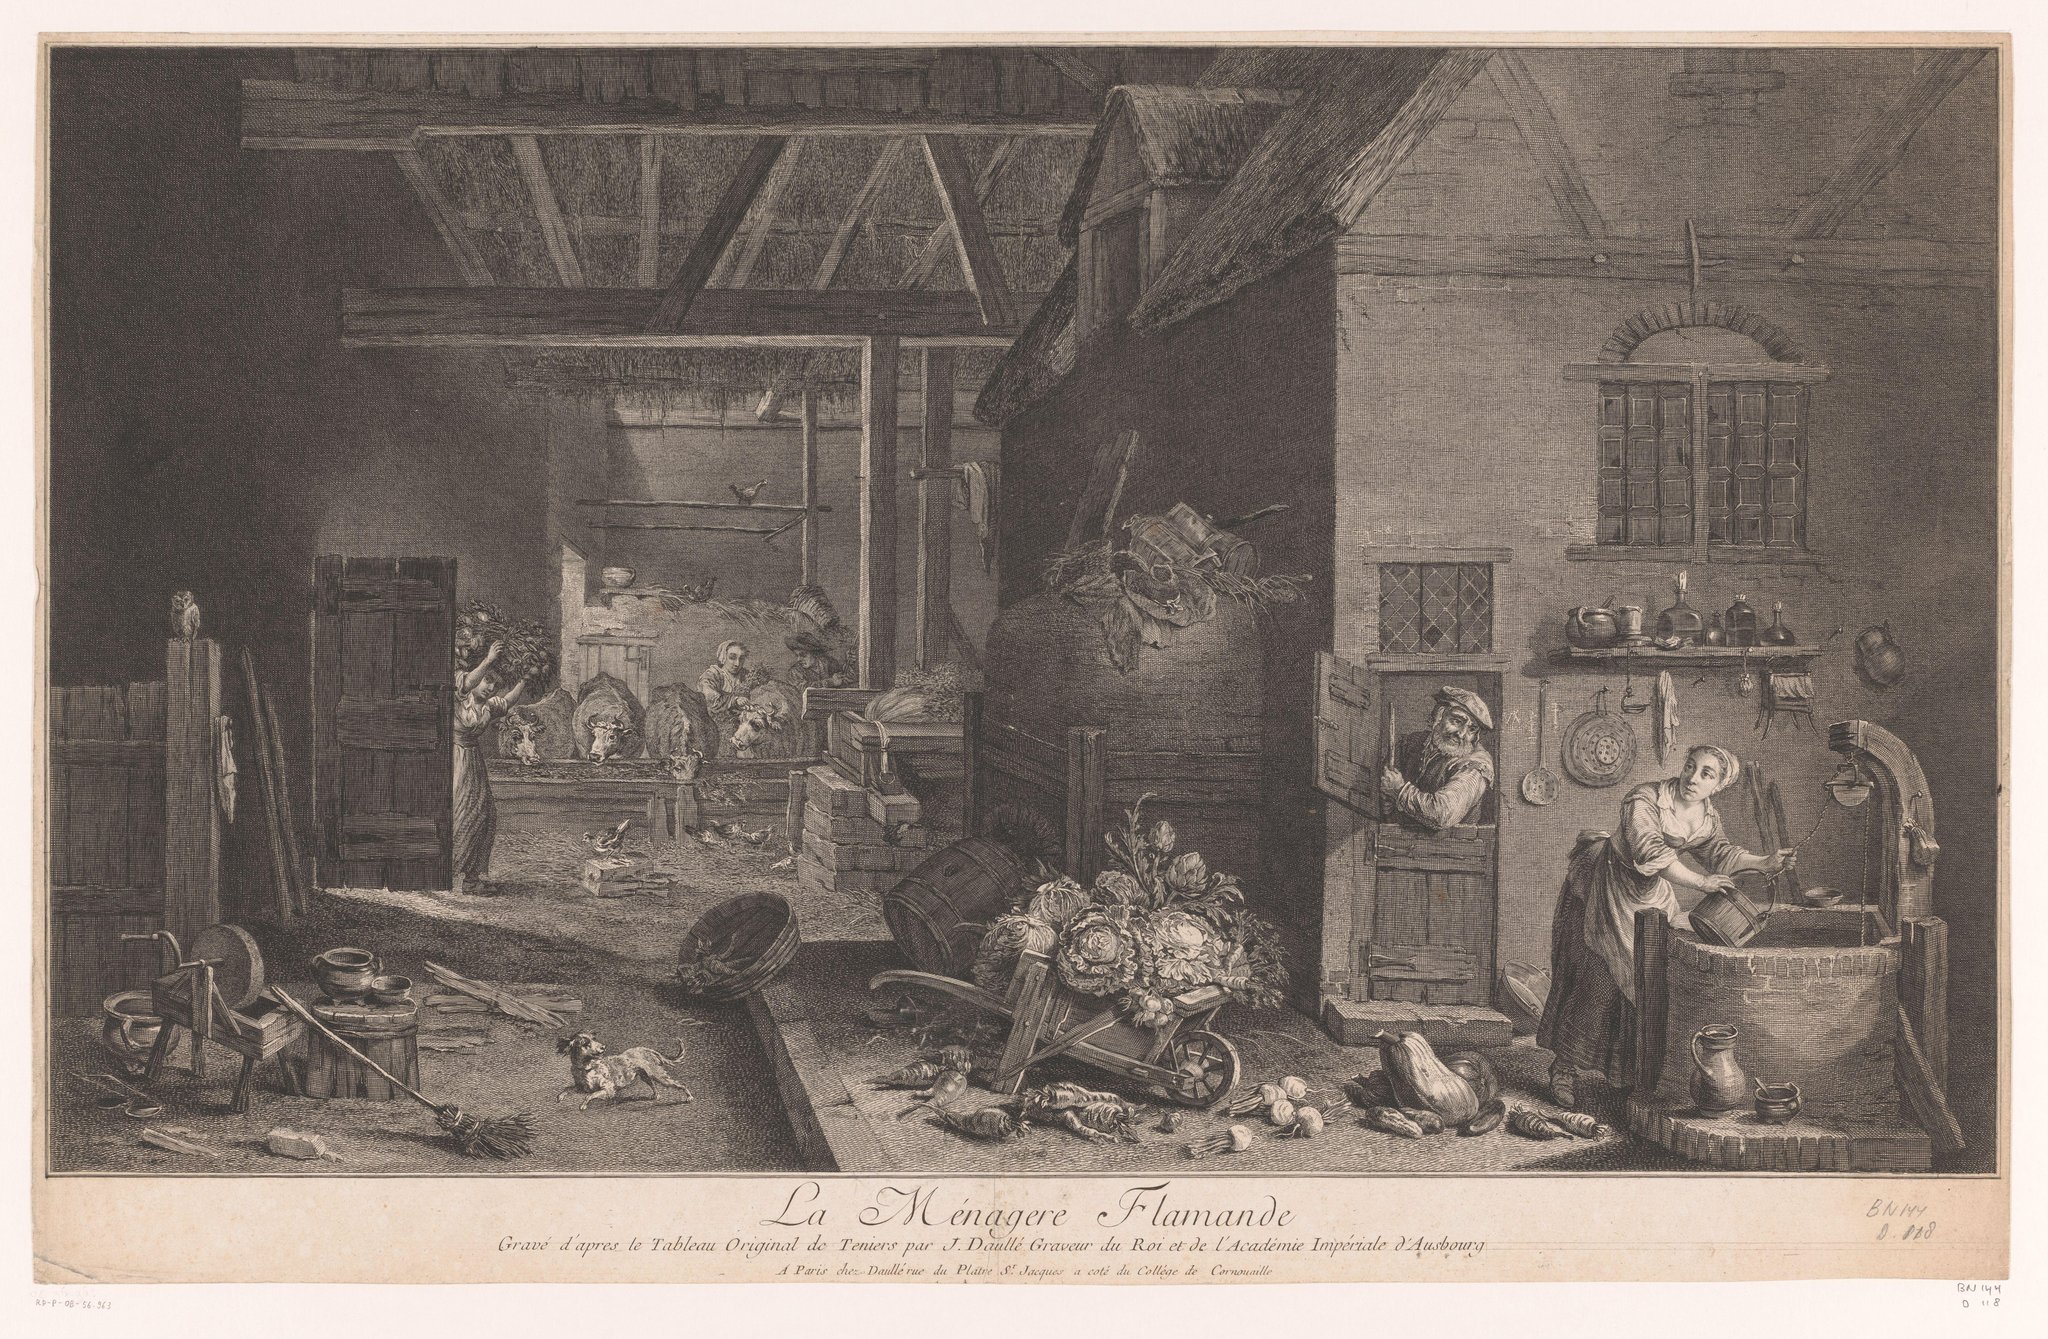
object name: print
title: La Ménagere Flamande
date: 1759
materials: paper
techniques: engraving, etching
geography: paris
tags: cow, interior, interiority, farm (building)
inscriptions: collector's mark: Lugt 240